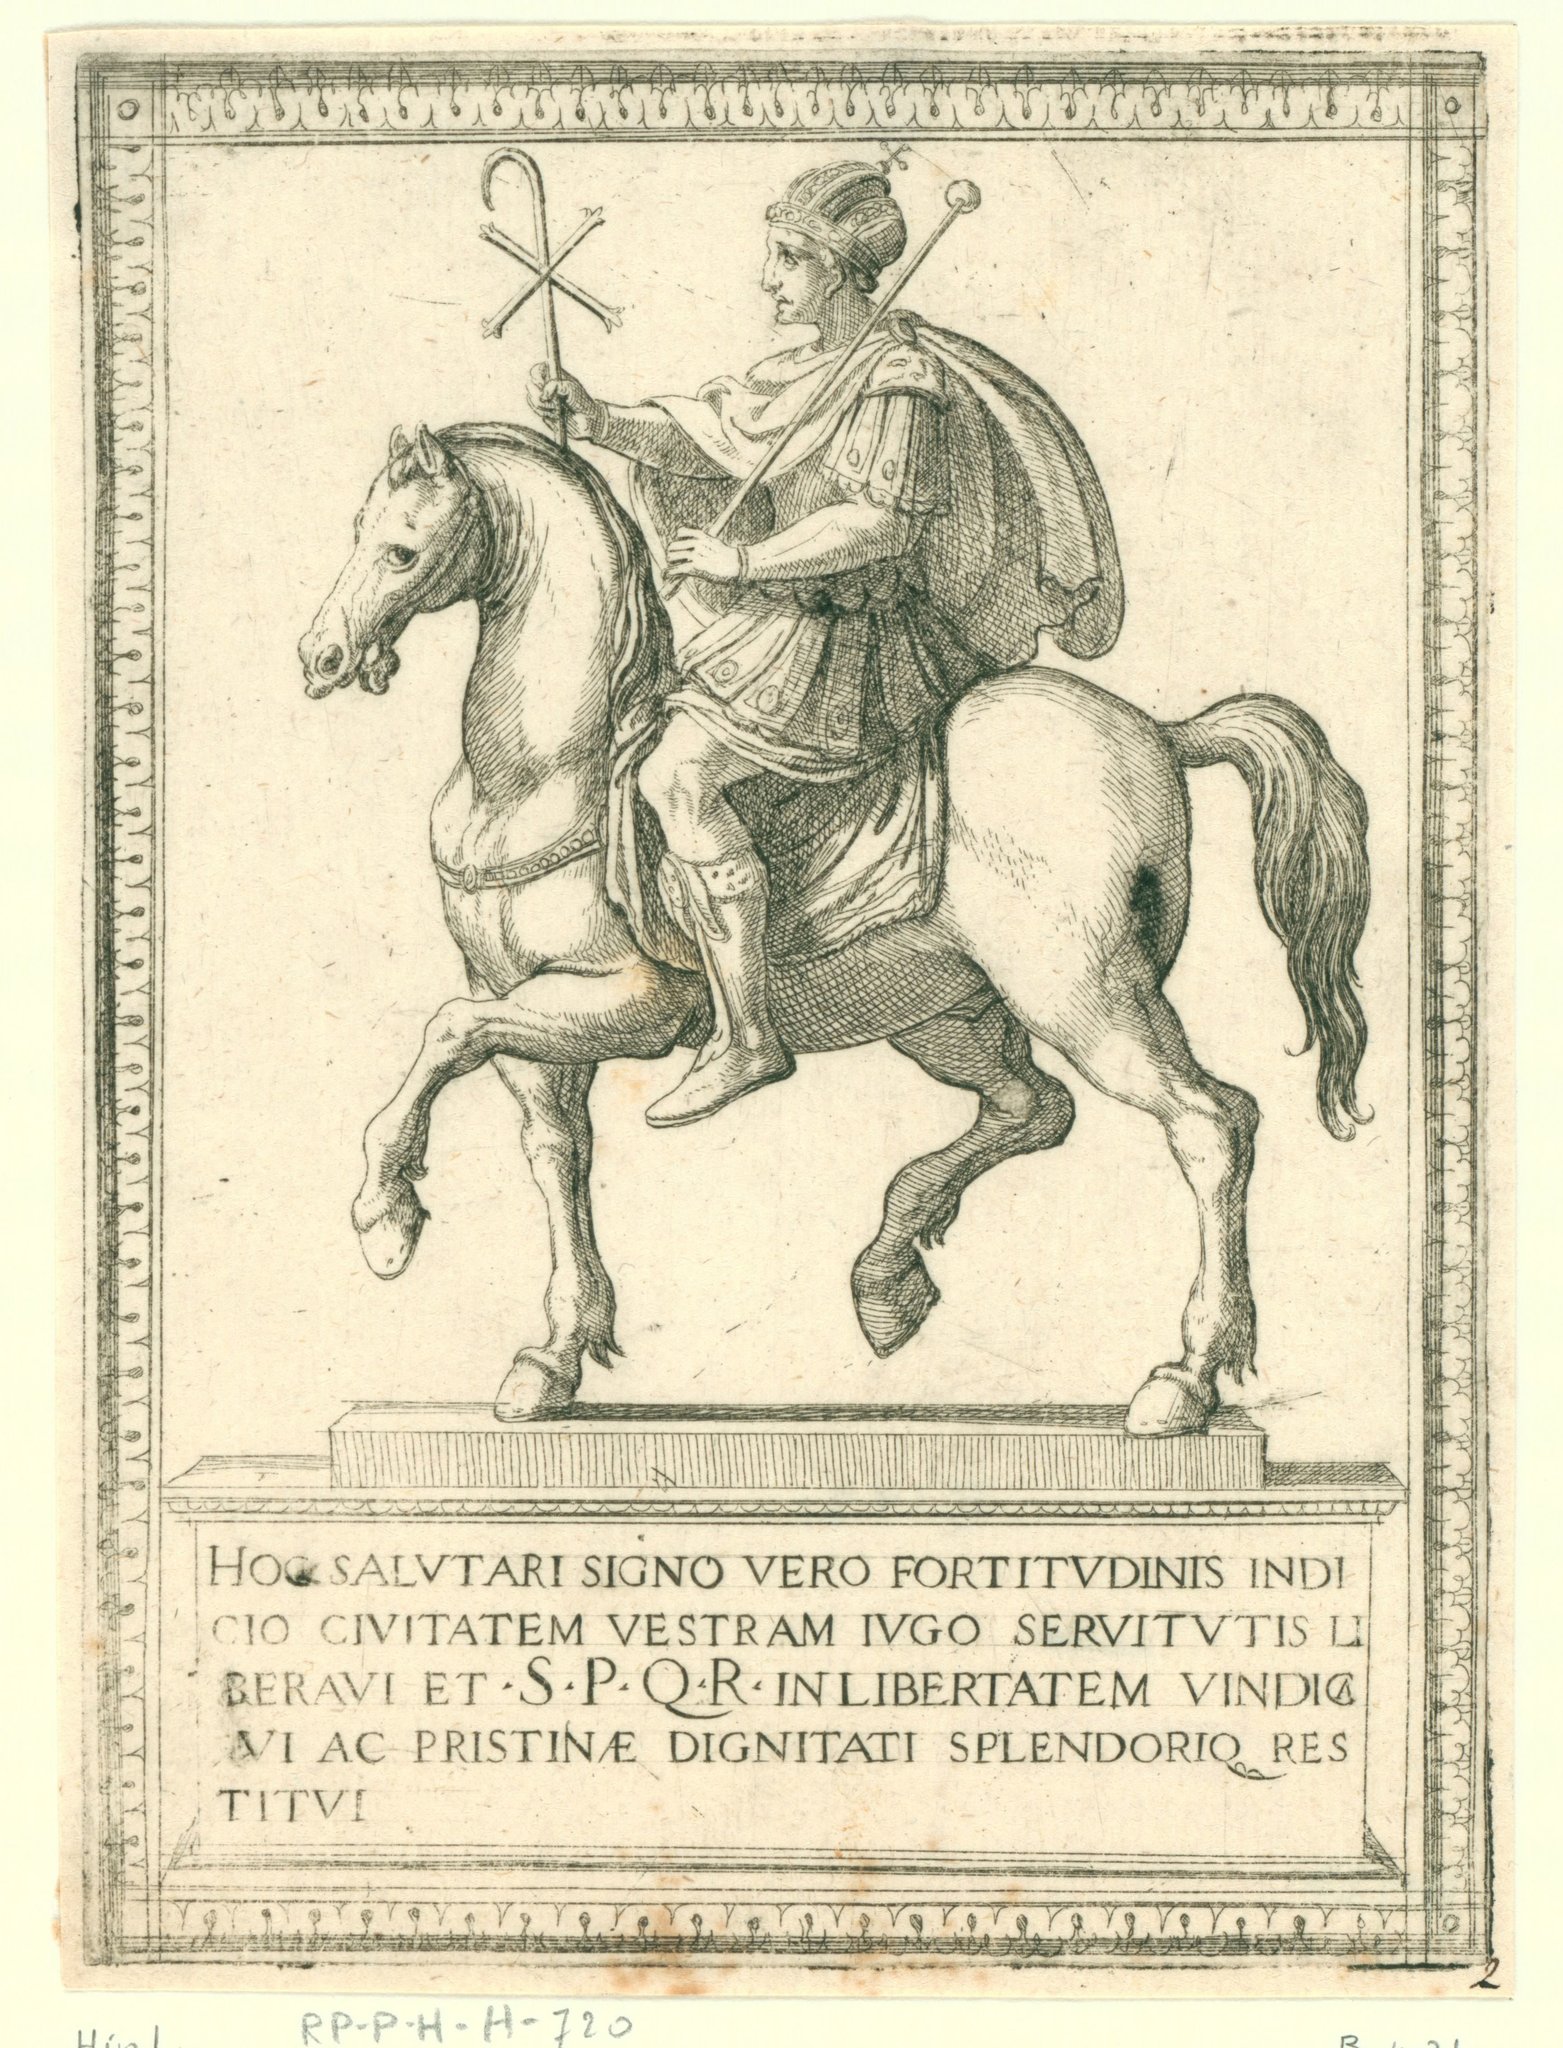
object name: print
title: Ruiterstandbeeld van keizer Constantijn de Grote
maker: antonio tempesta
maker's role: draughtsman, painter, print maker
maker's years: 1555-1630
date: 1565-1630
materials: paper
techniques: etching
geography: italy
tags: equestrian statue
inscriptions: collector's mark: ‘Hinloopen’, collector's mark: Lugt 11, number: ‘2’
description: Deze prent maakt deel uit van een reeks van veertien prenten (+ titelprent) met de geschiedenis van de Orde van de heilige Joris.